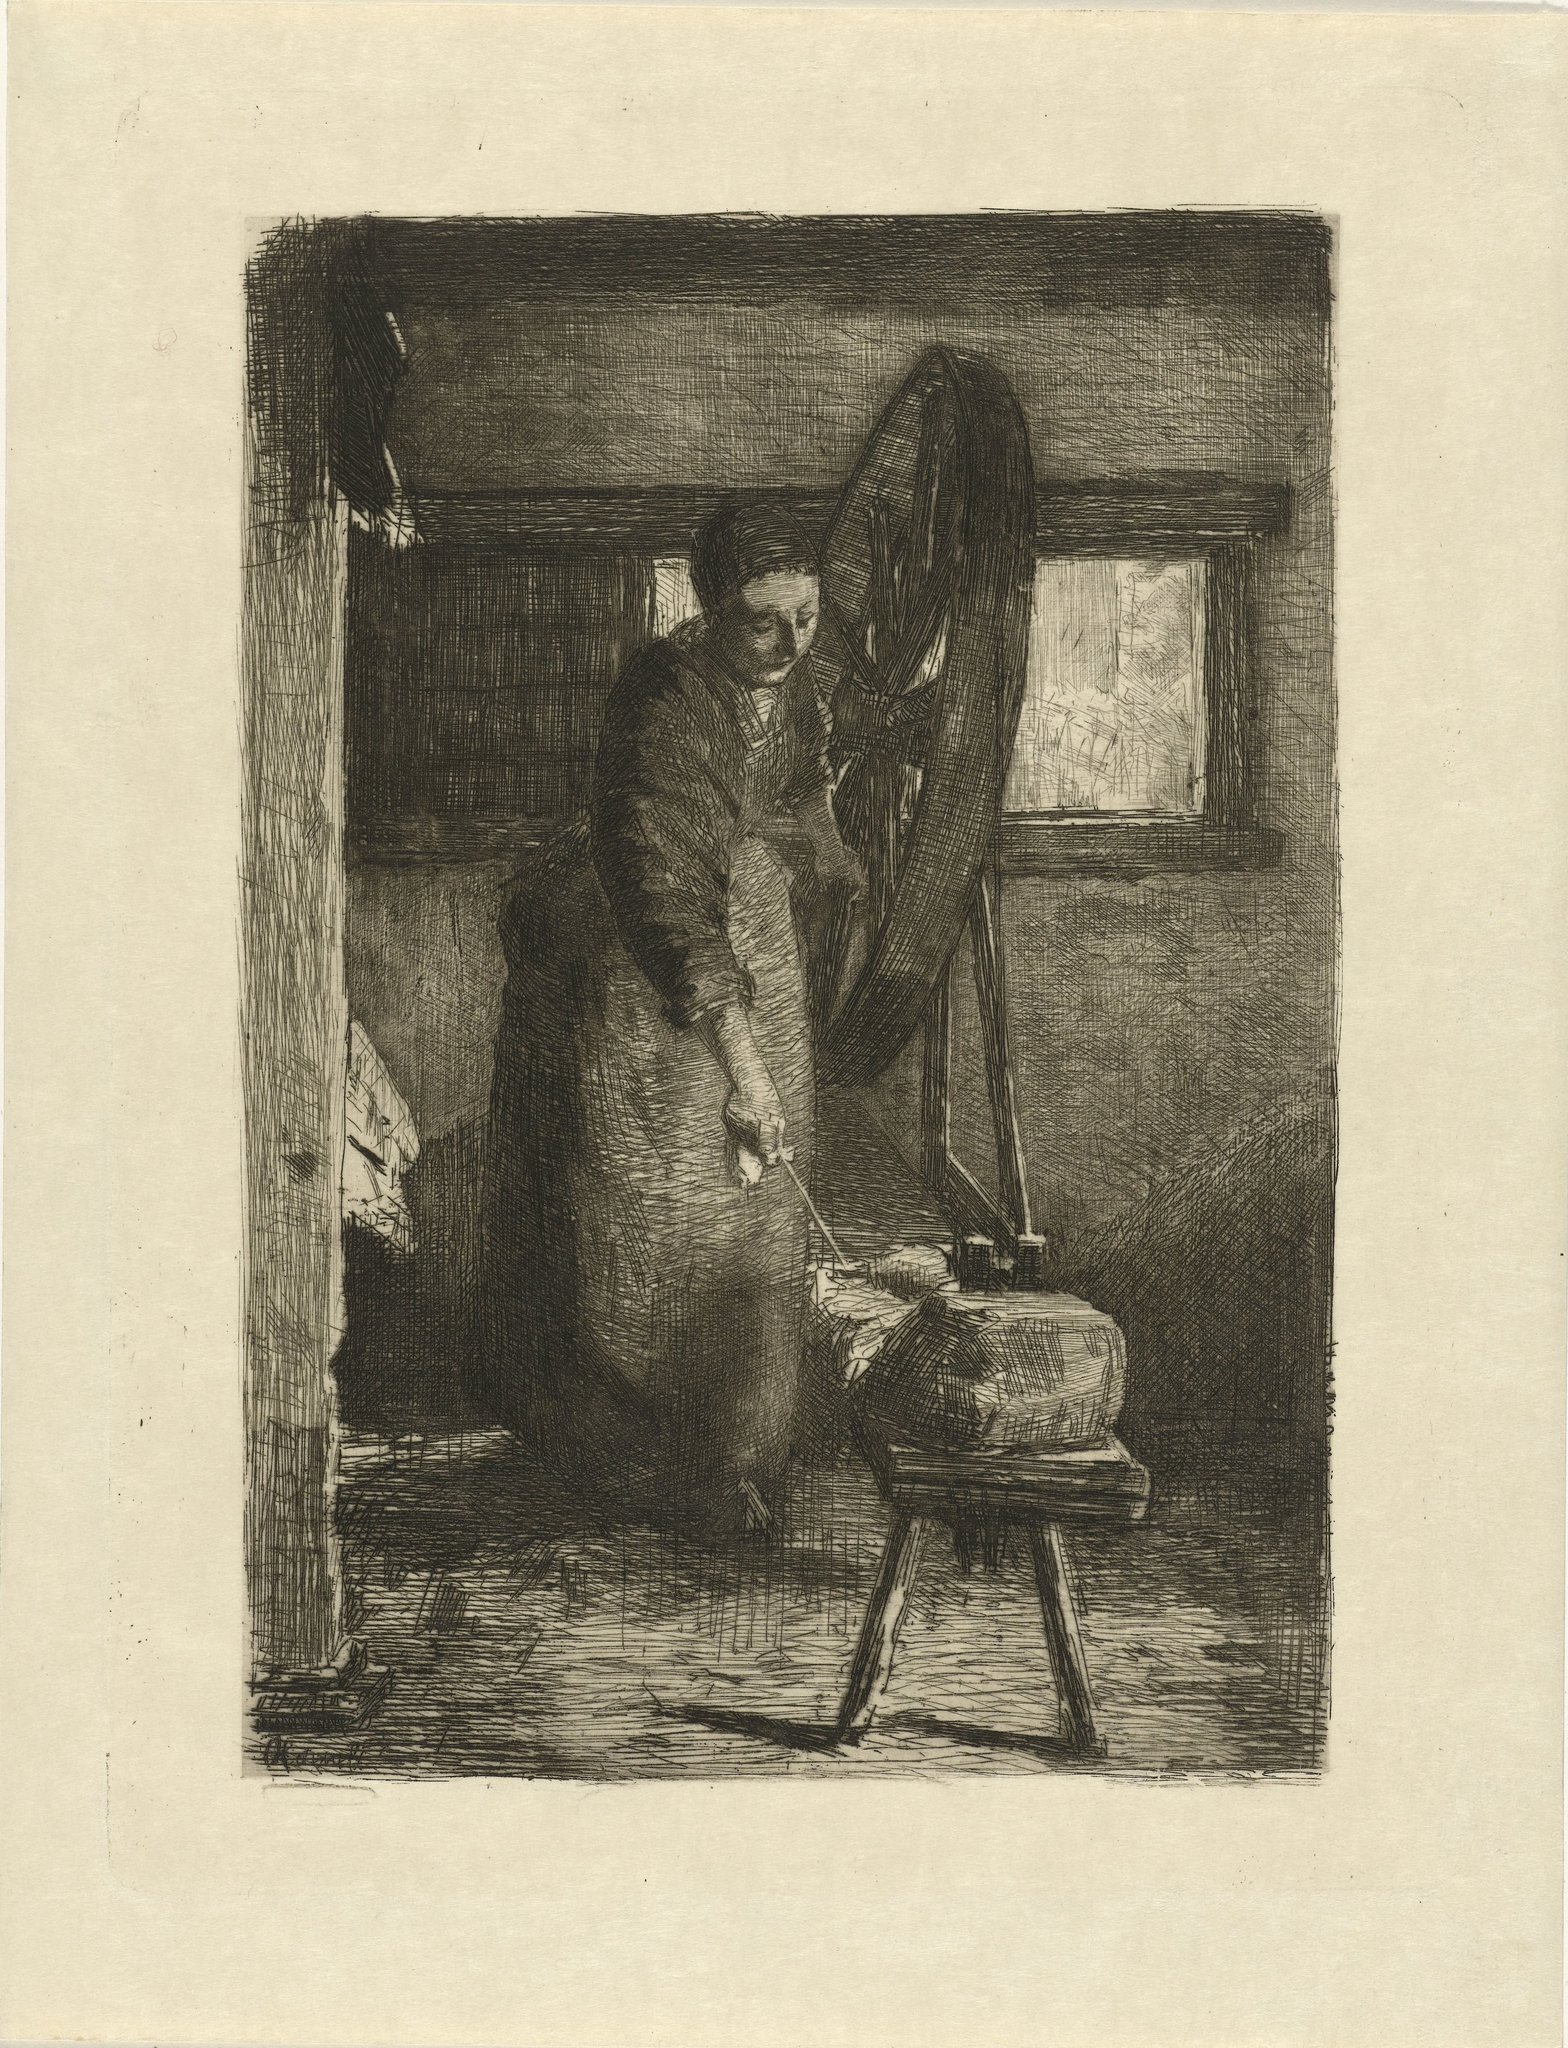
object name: print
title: Aan den arbeid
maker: ferdinand oldewelt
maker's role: draughtsman, print maker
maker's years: 1857-1935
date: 1872-1897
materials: paper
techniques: drypoint, etching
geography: netherlands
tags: spinning-wheel, spinning (manufacture of yarn)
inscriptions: collector's mark: Lugt 2228